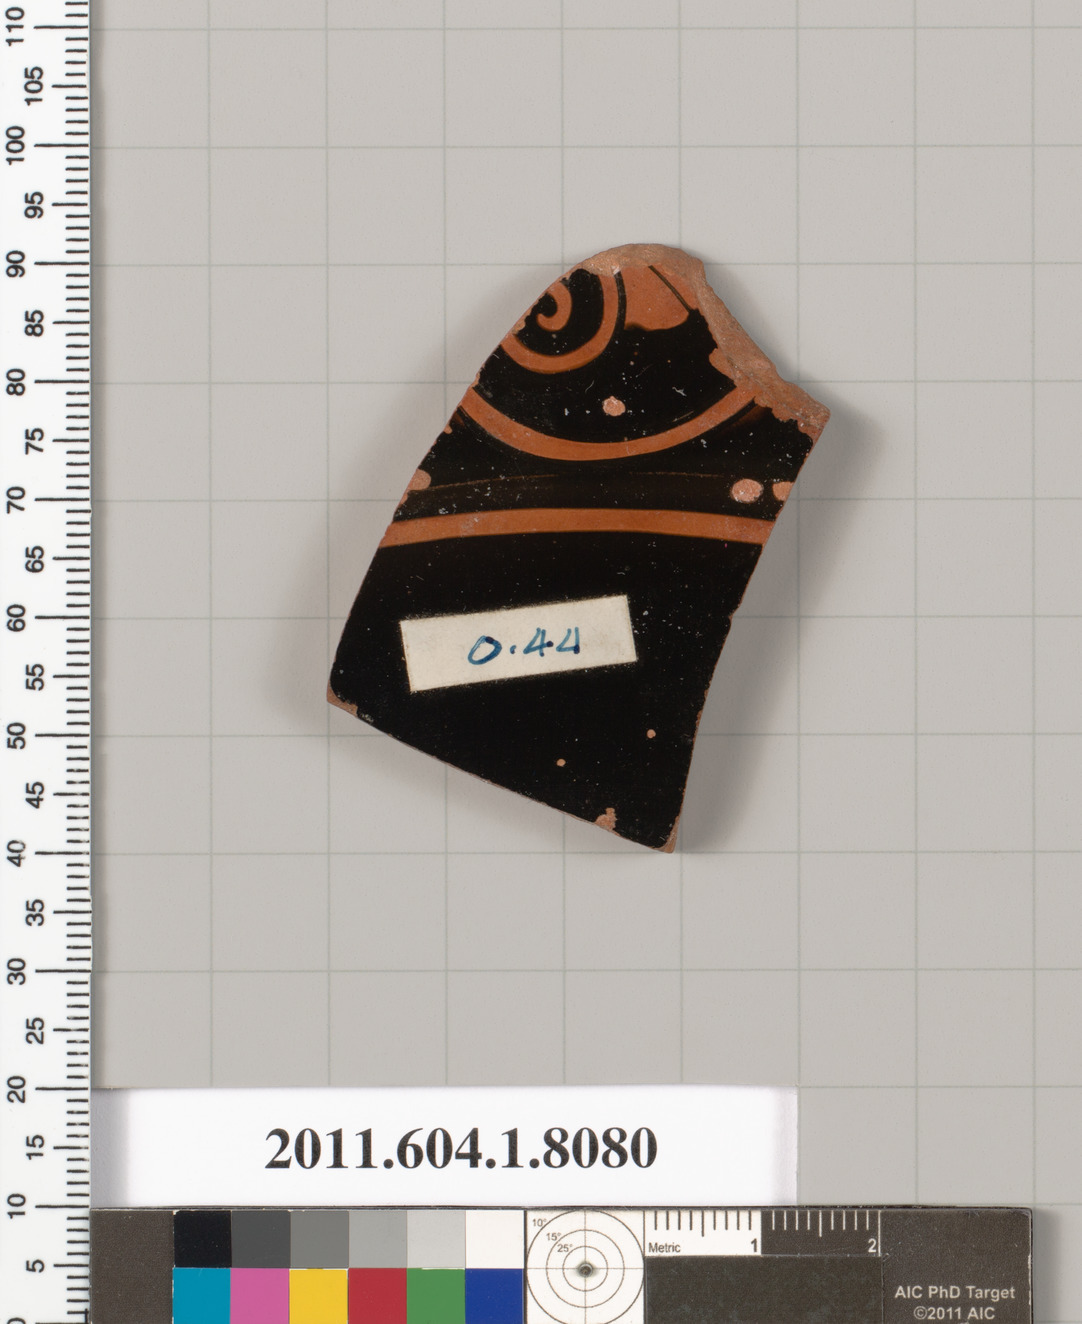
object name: kylix fragment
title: Terracotta fragment of a kylix (drinking cup)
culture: greek, attic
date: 510-500 BCE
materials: terracotta